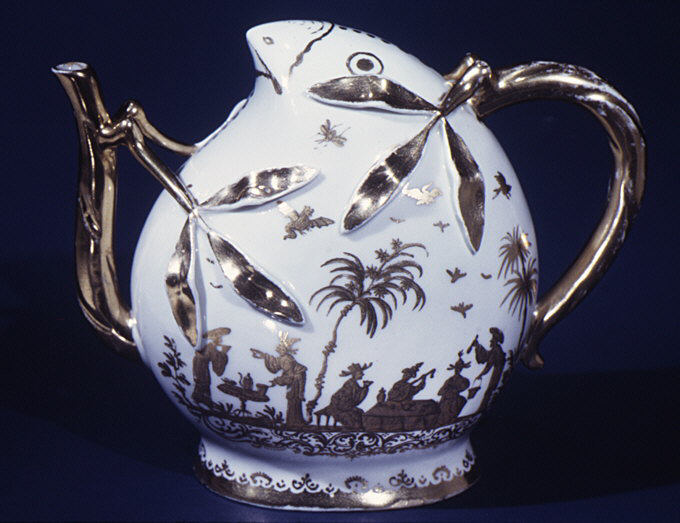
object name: teapot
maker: meissen manufactory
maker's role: manufactory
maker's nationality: german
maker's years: 1710-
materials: hard paste porcelain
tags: human figures,trees